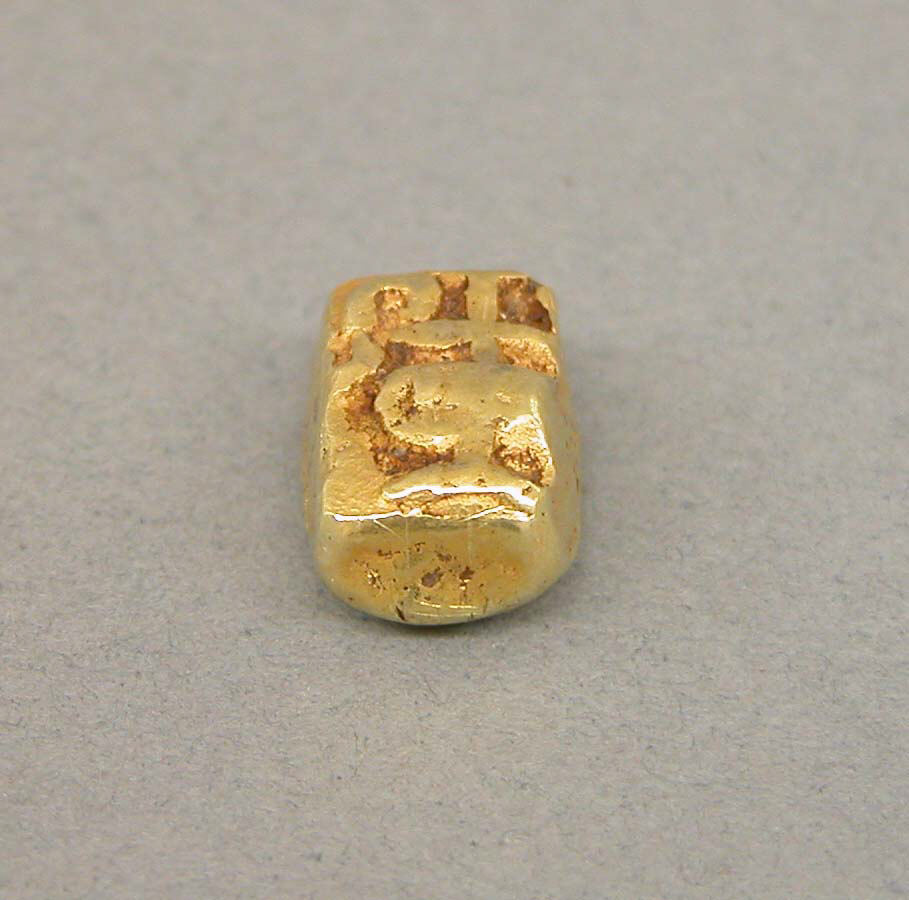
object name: coin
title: Large Piloncito Coin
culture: indonesian, javanese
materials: gold